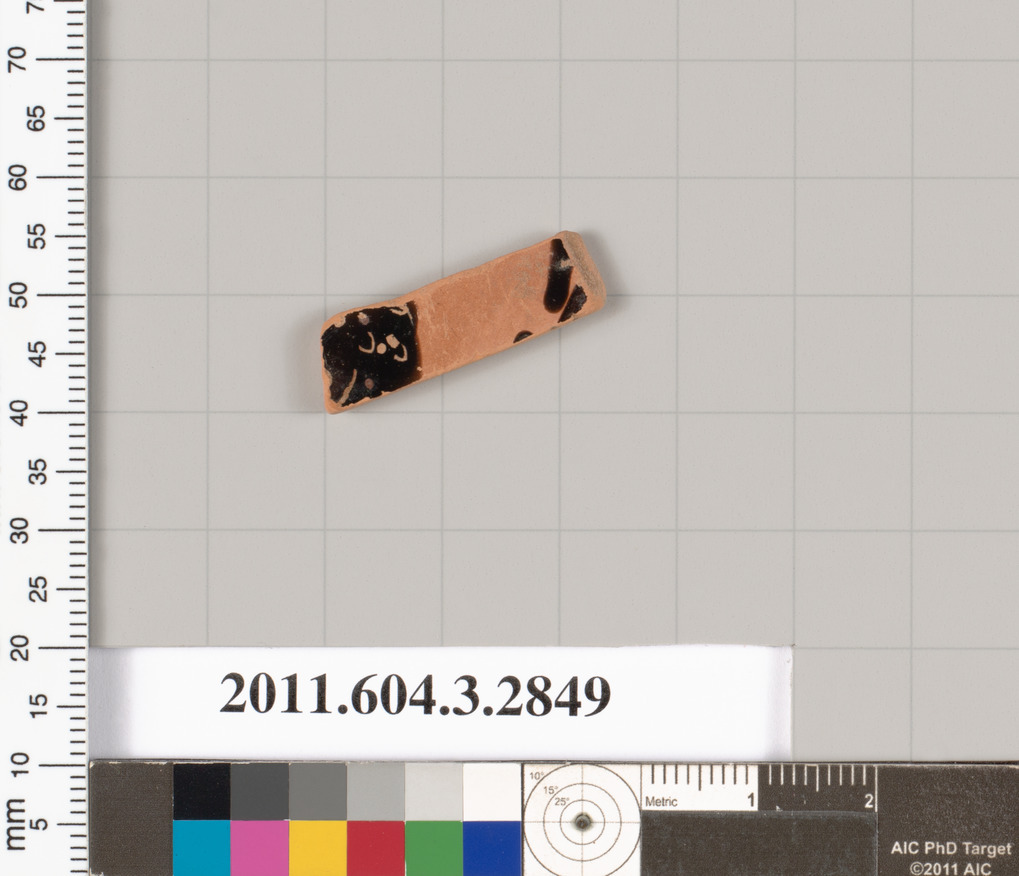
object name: undetermined closed shape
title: Terracotta fragment of a closed shape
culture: greek, attic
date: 534-468 BCE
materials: terracotta